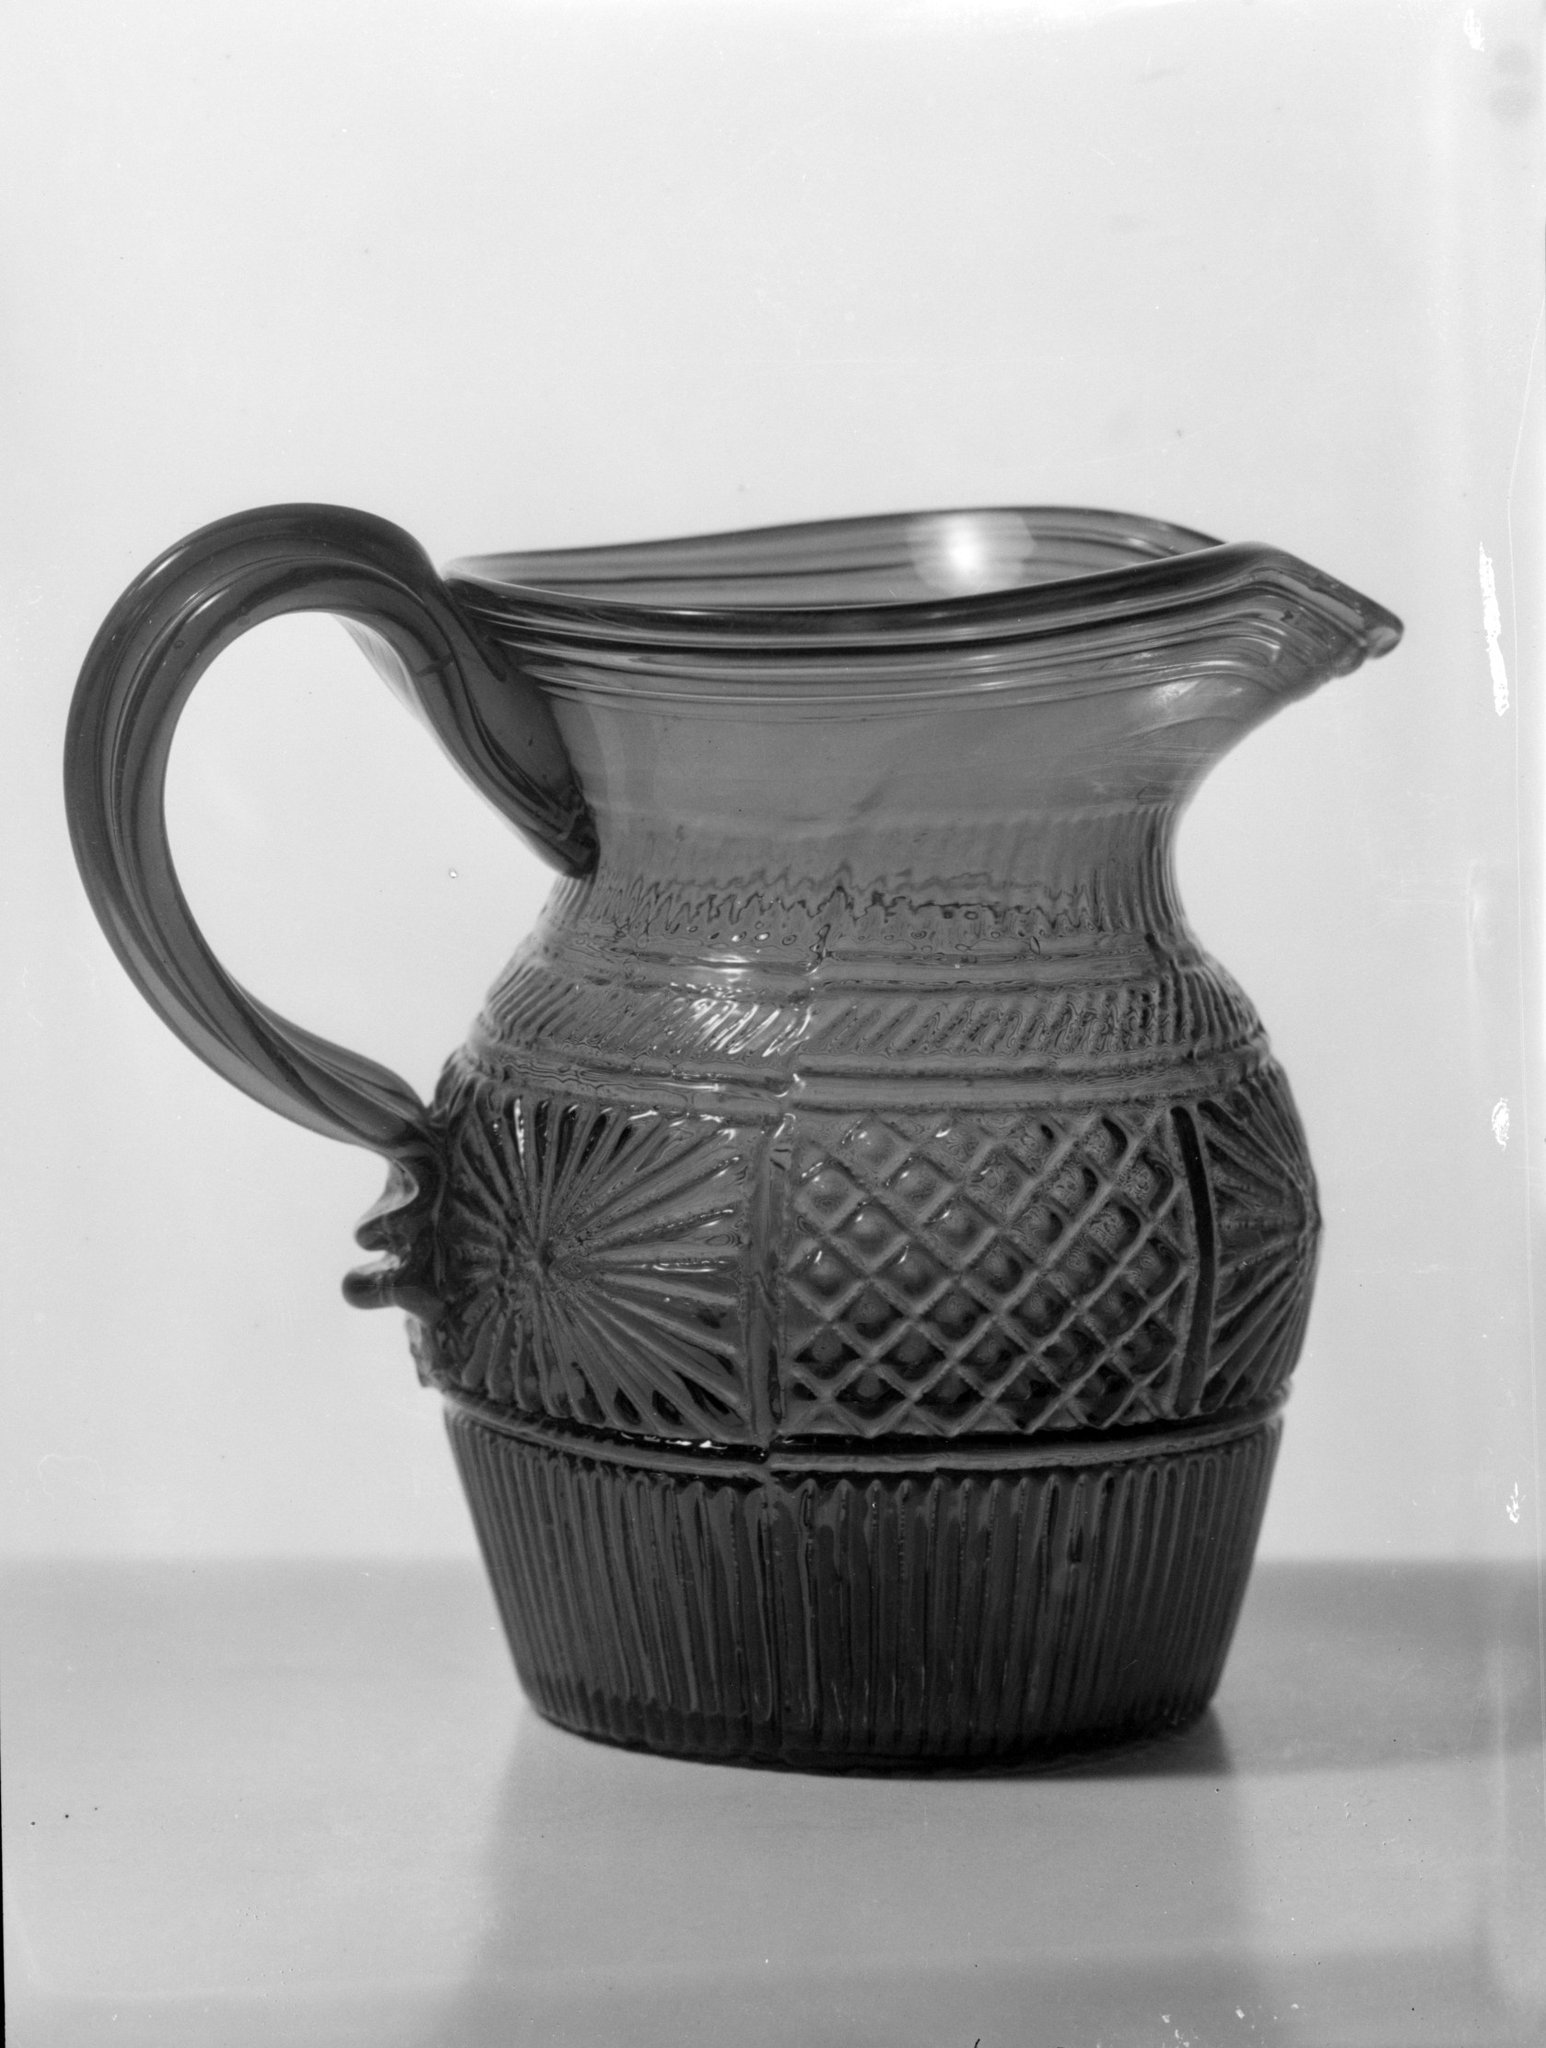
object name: pitcher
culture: american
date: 1820-1840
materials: glass, lead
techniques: glassblowing, molding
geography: united states